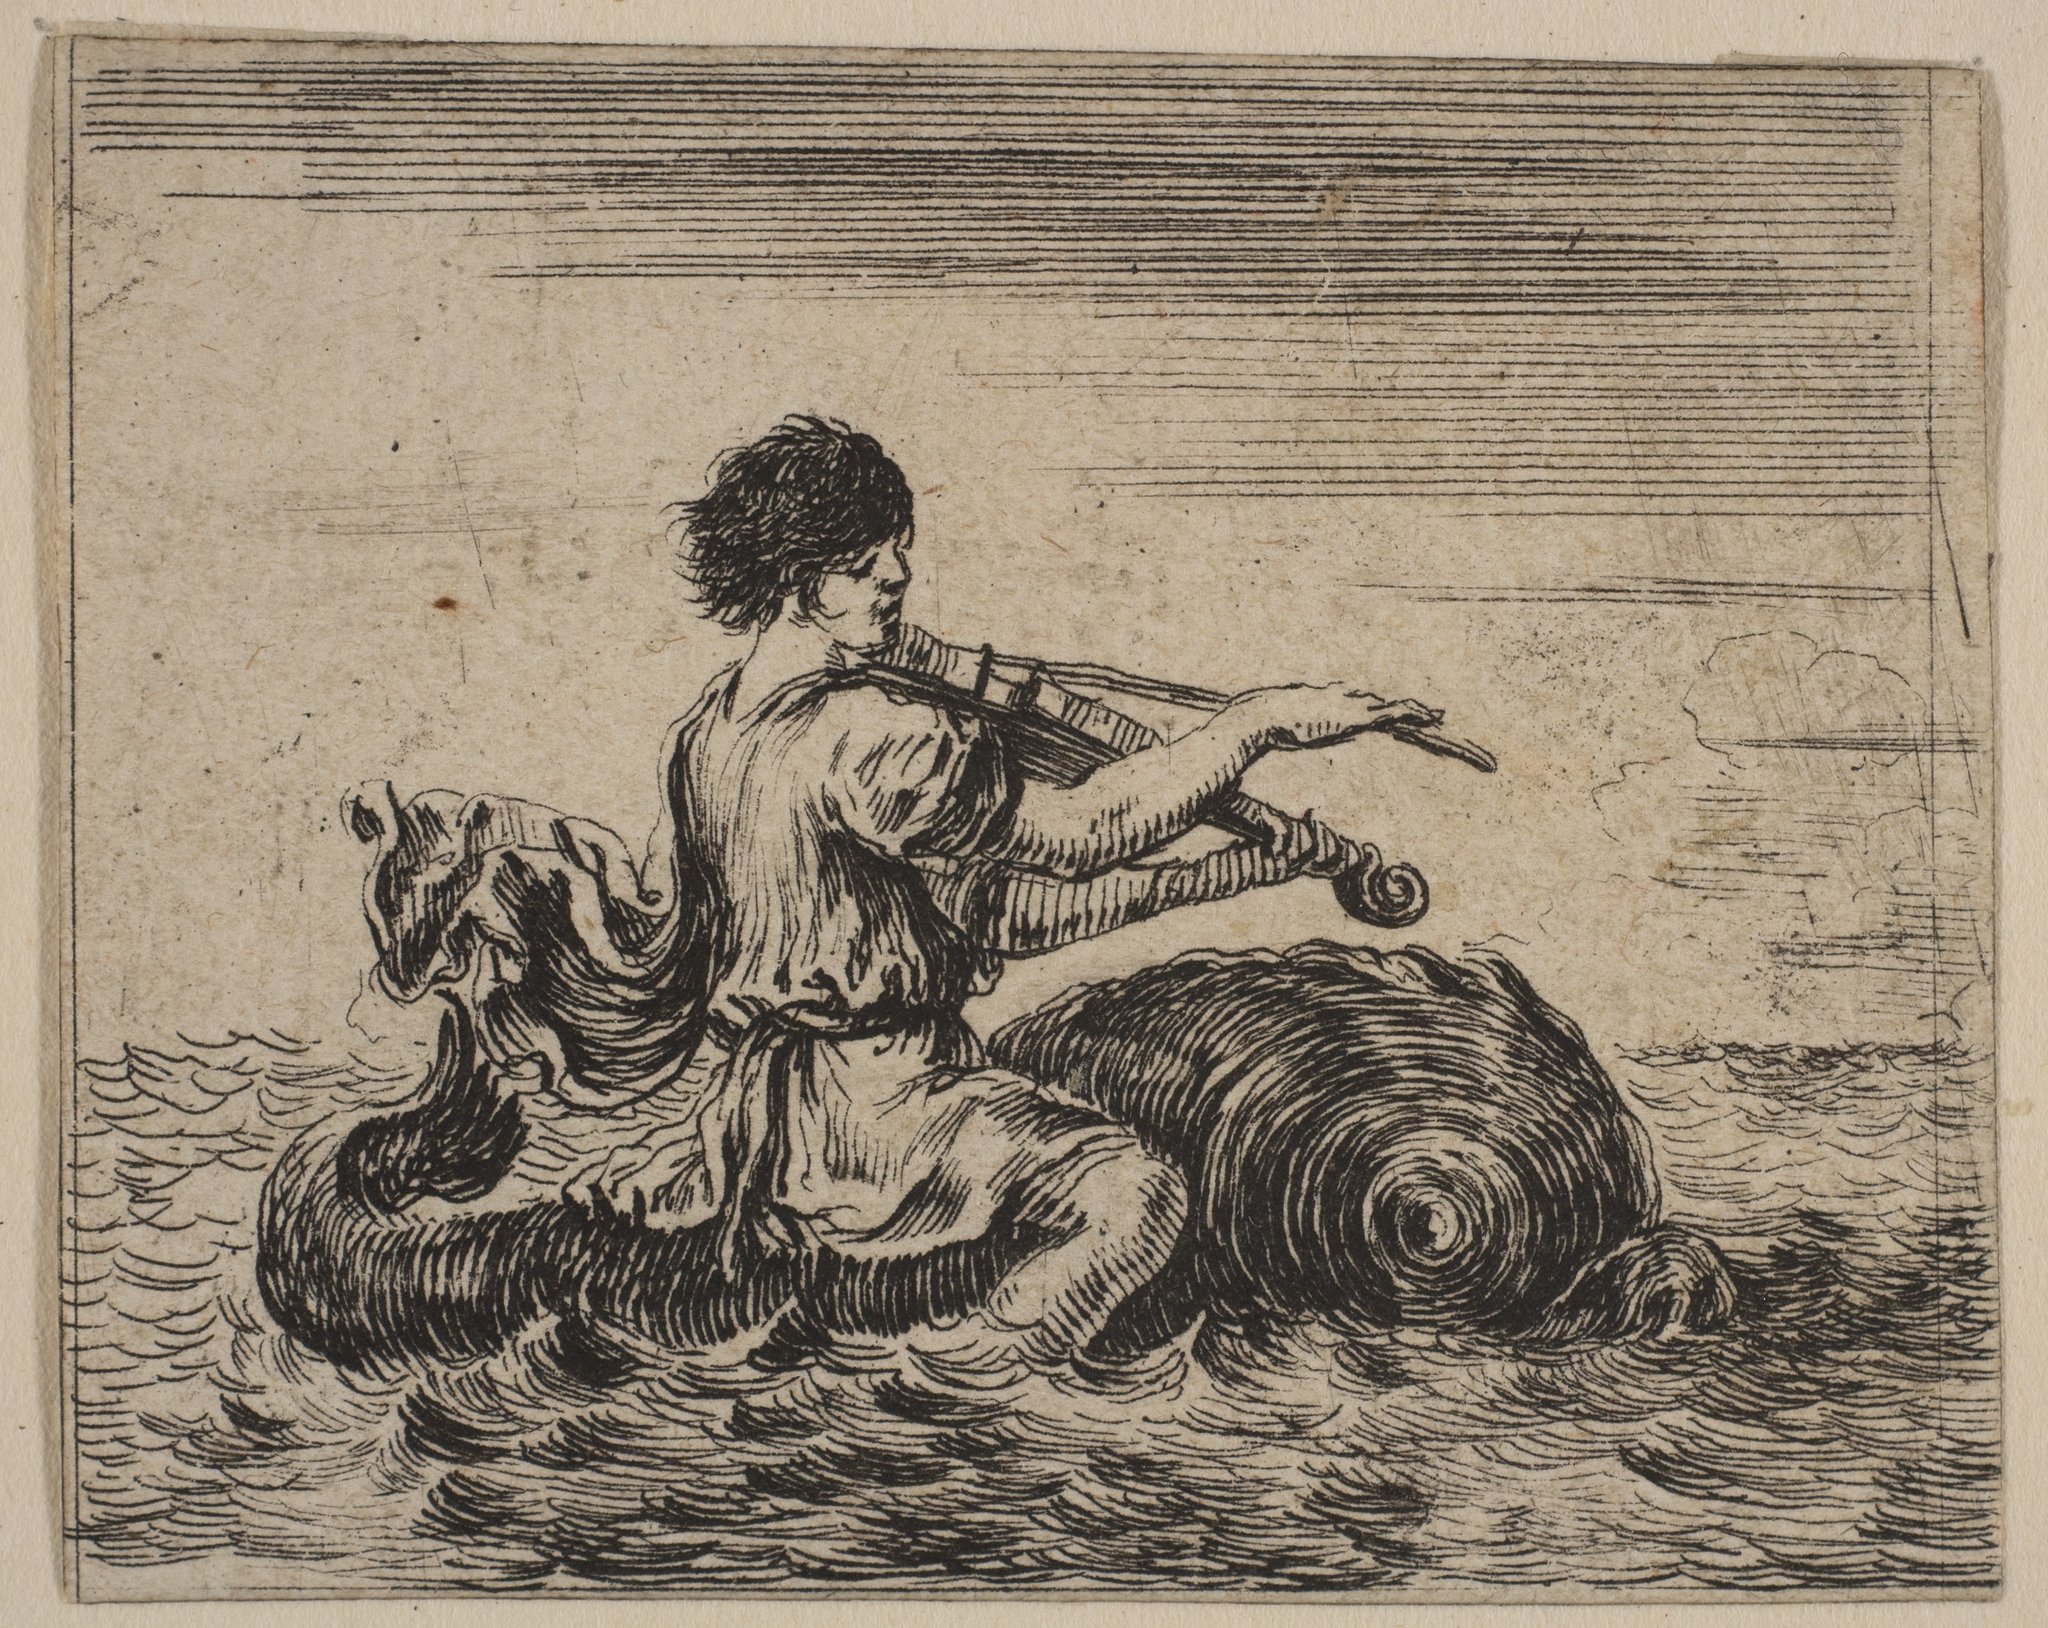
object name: print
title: Arion, from 'Game of Mythology' (Jeu de la Mythologie)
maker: stefano della bella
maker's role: artist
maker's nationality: italian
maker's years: 1610-1664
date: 1644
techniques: etching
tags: men,violins,dolphins